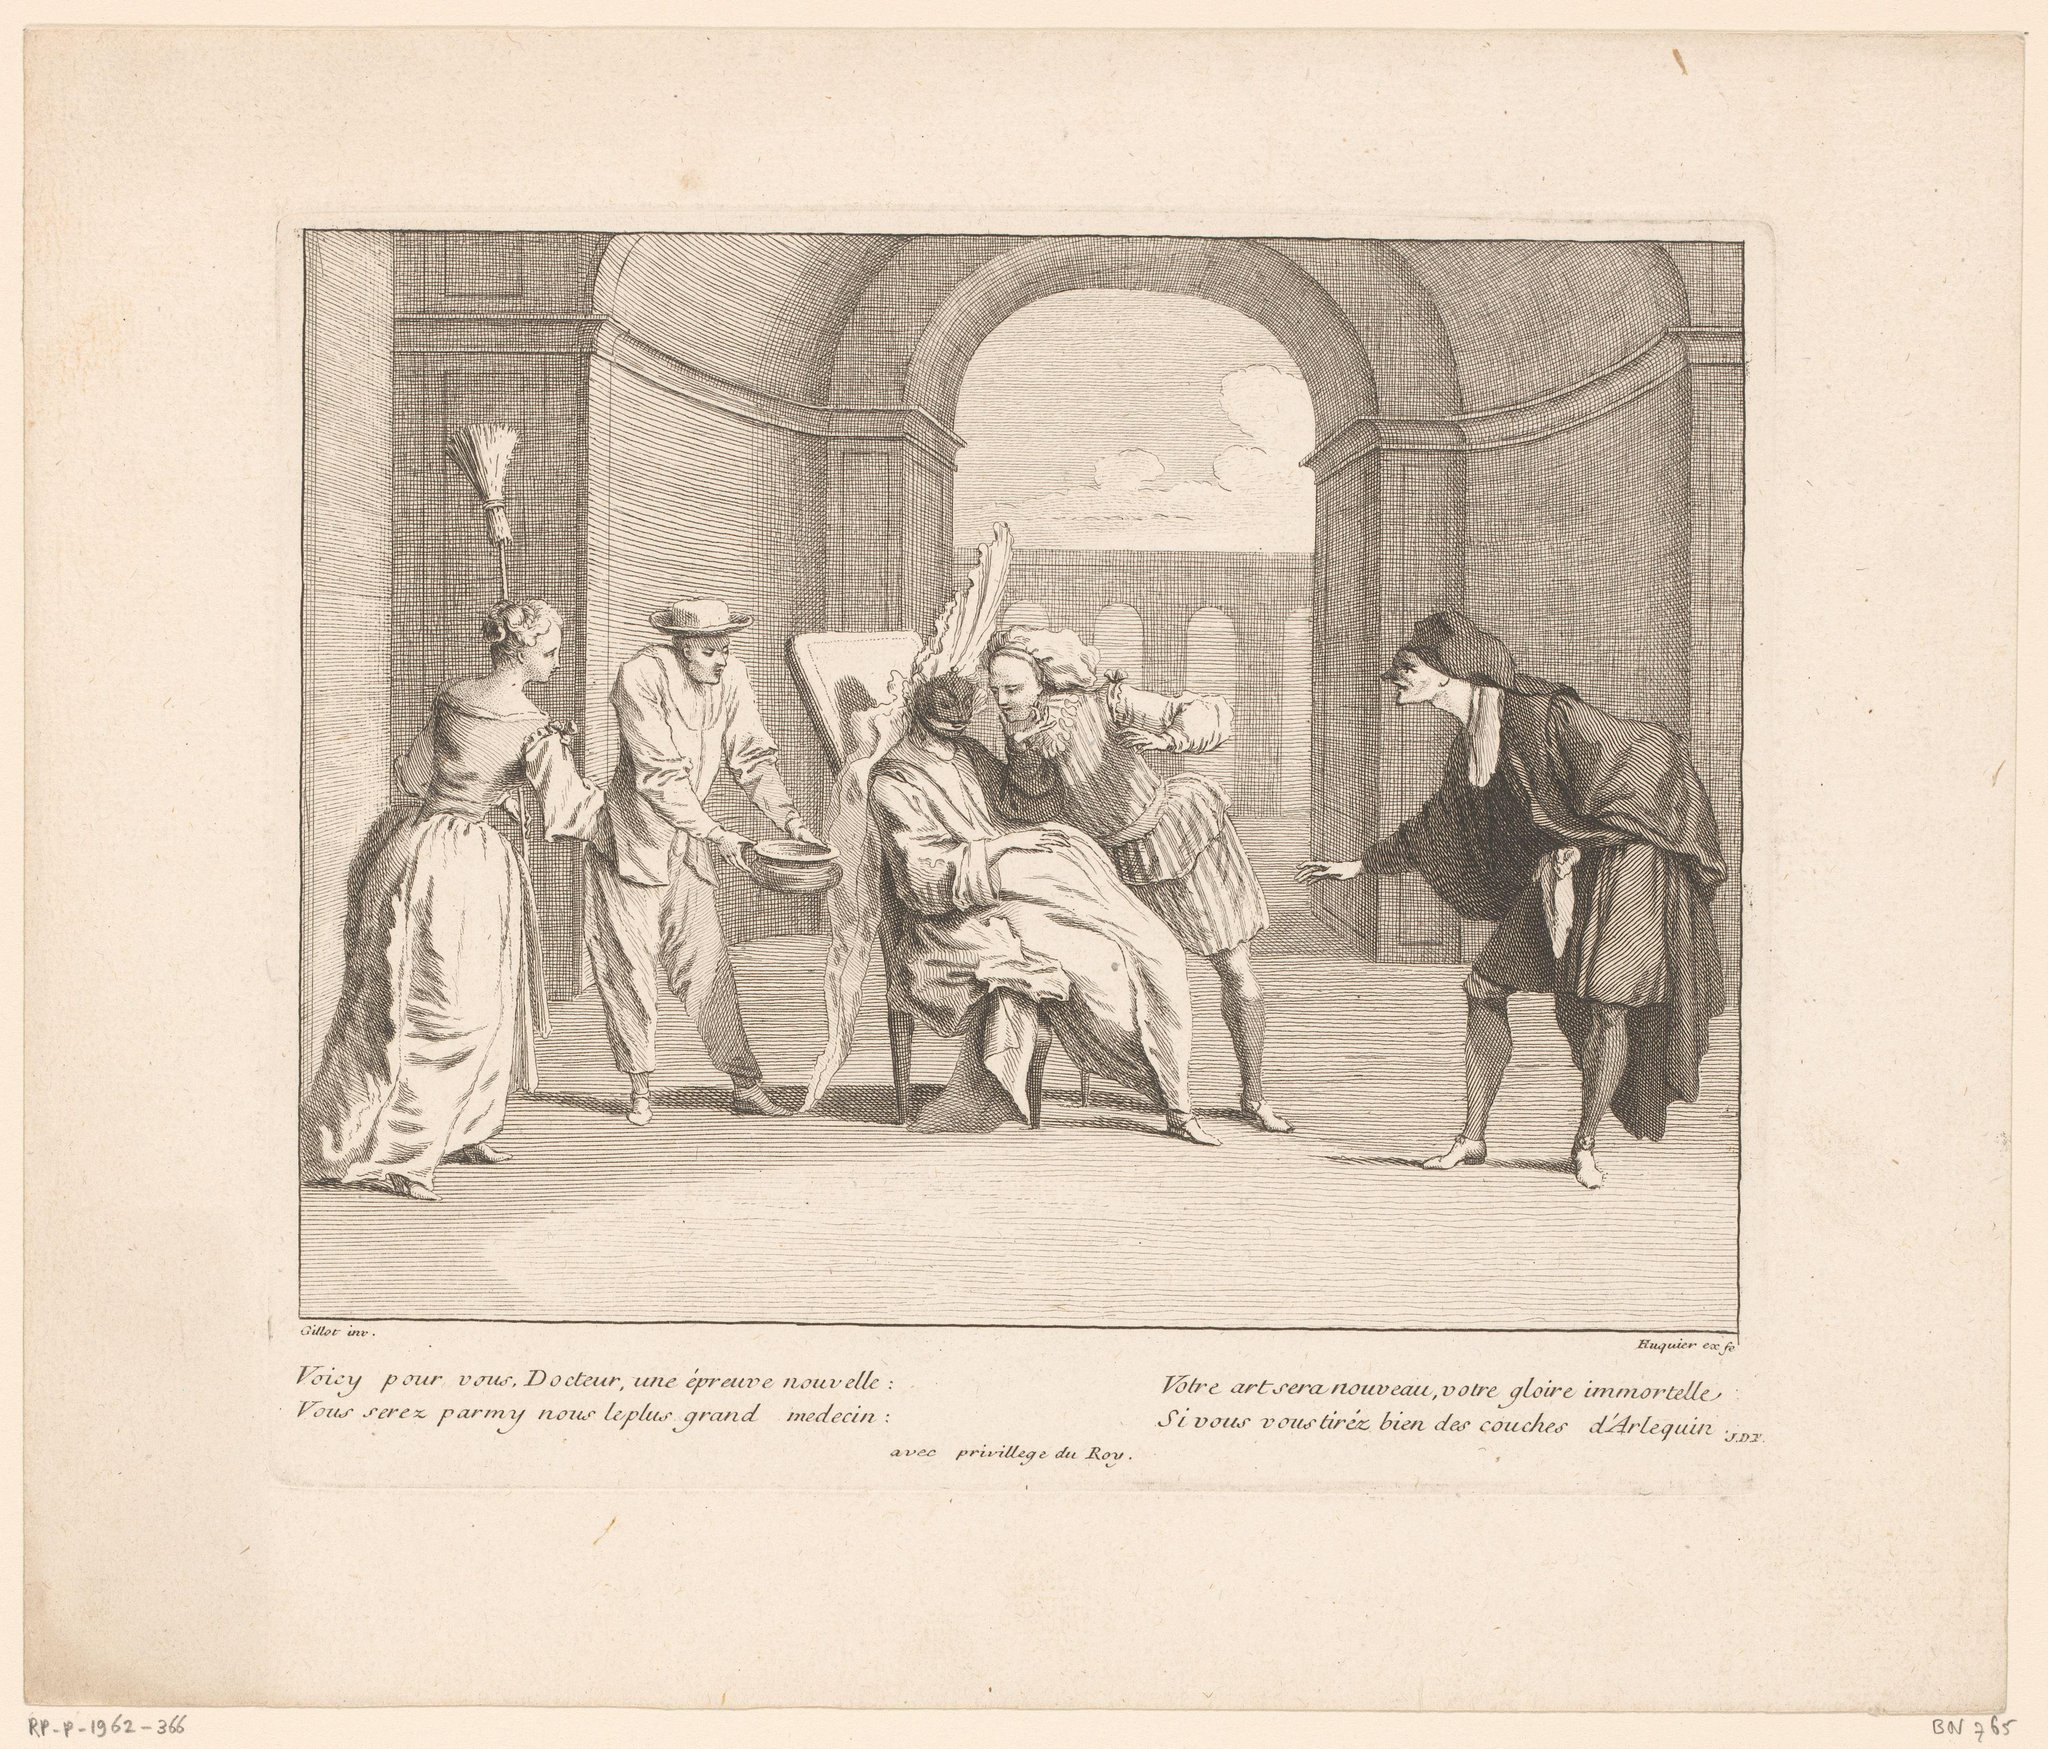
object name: print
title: Scènes uit de Commedia dell'arte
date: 1729-1732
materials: paper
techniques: etching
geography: france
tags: types in 'commedia dell'arte': harlequin, 'commedia dell'arte'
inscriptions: collector's mark: Lugt 2228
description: Maakt deel uit van een serie van twaalf prenten met scènes uit de Commedia dell'arte door Huquier naar tekeningen door Gillot. De serie werd tussen 1729 en 1732 uitgegeven door Huquier en de weduwe van François Chéreau.